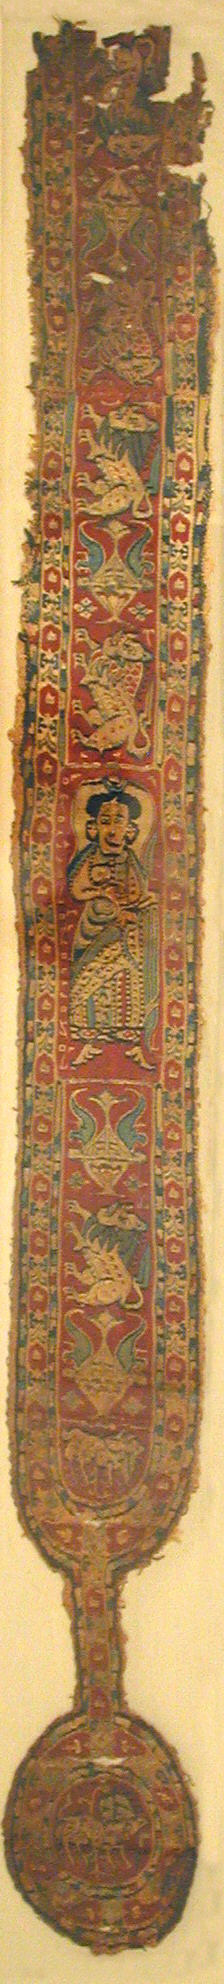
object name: textile fragment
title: Vertical Band from a Tunic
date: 601-700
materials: linen, wool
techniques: weave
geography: egypt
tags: women,lions